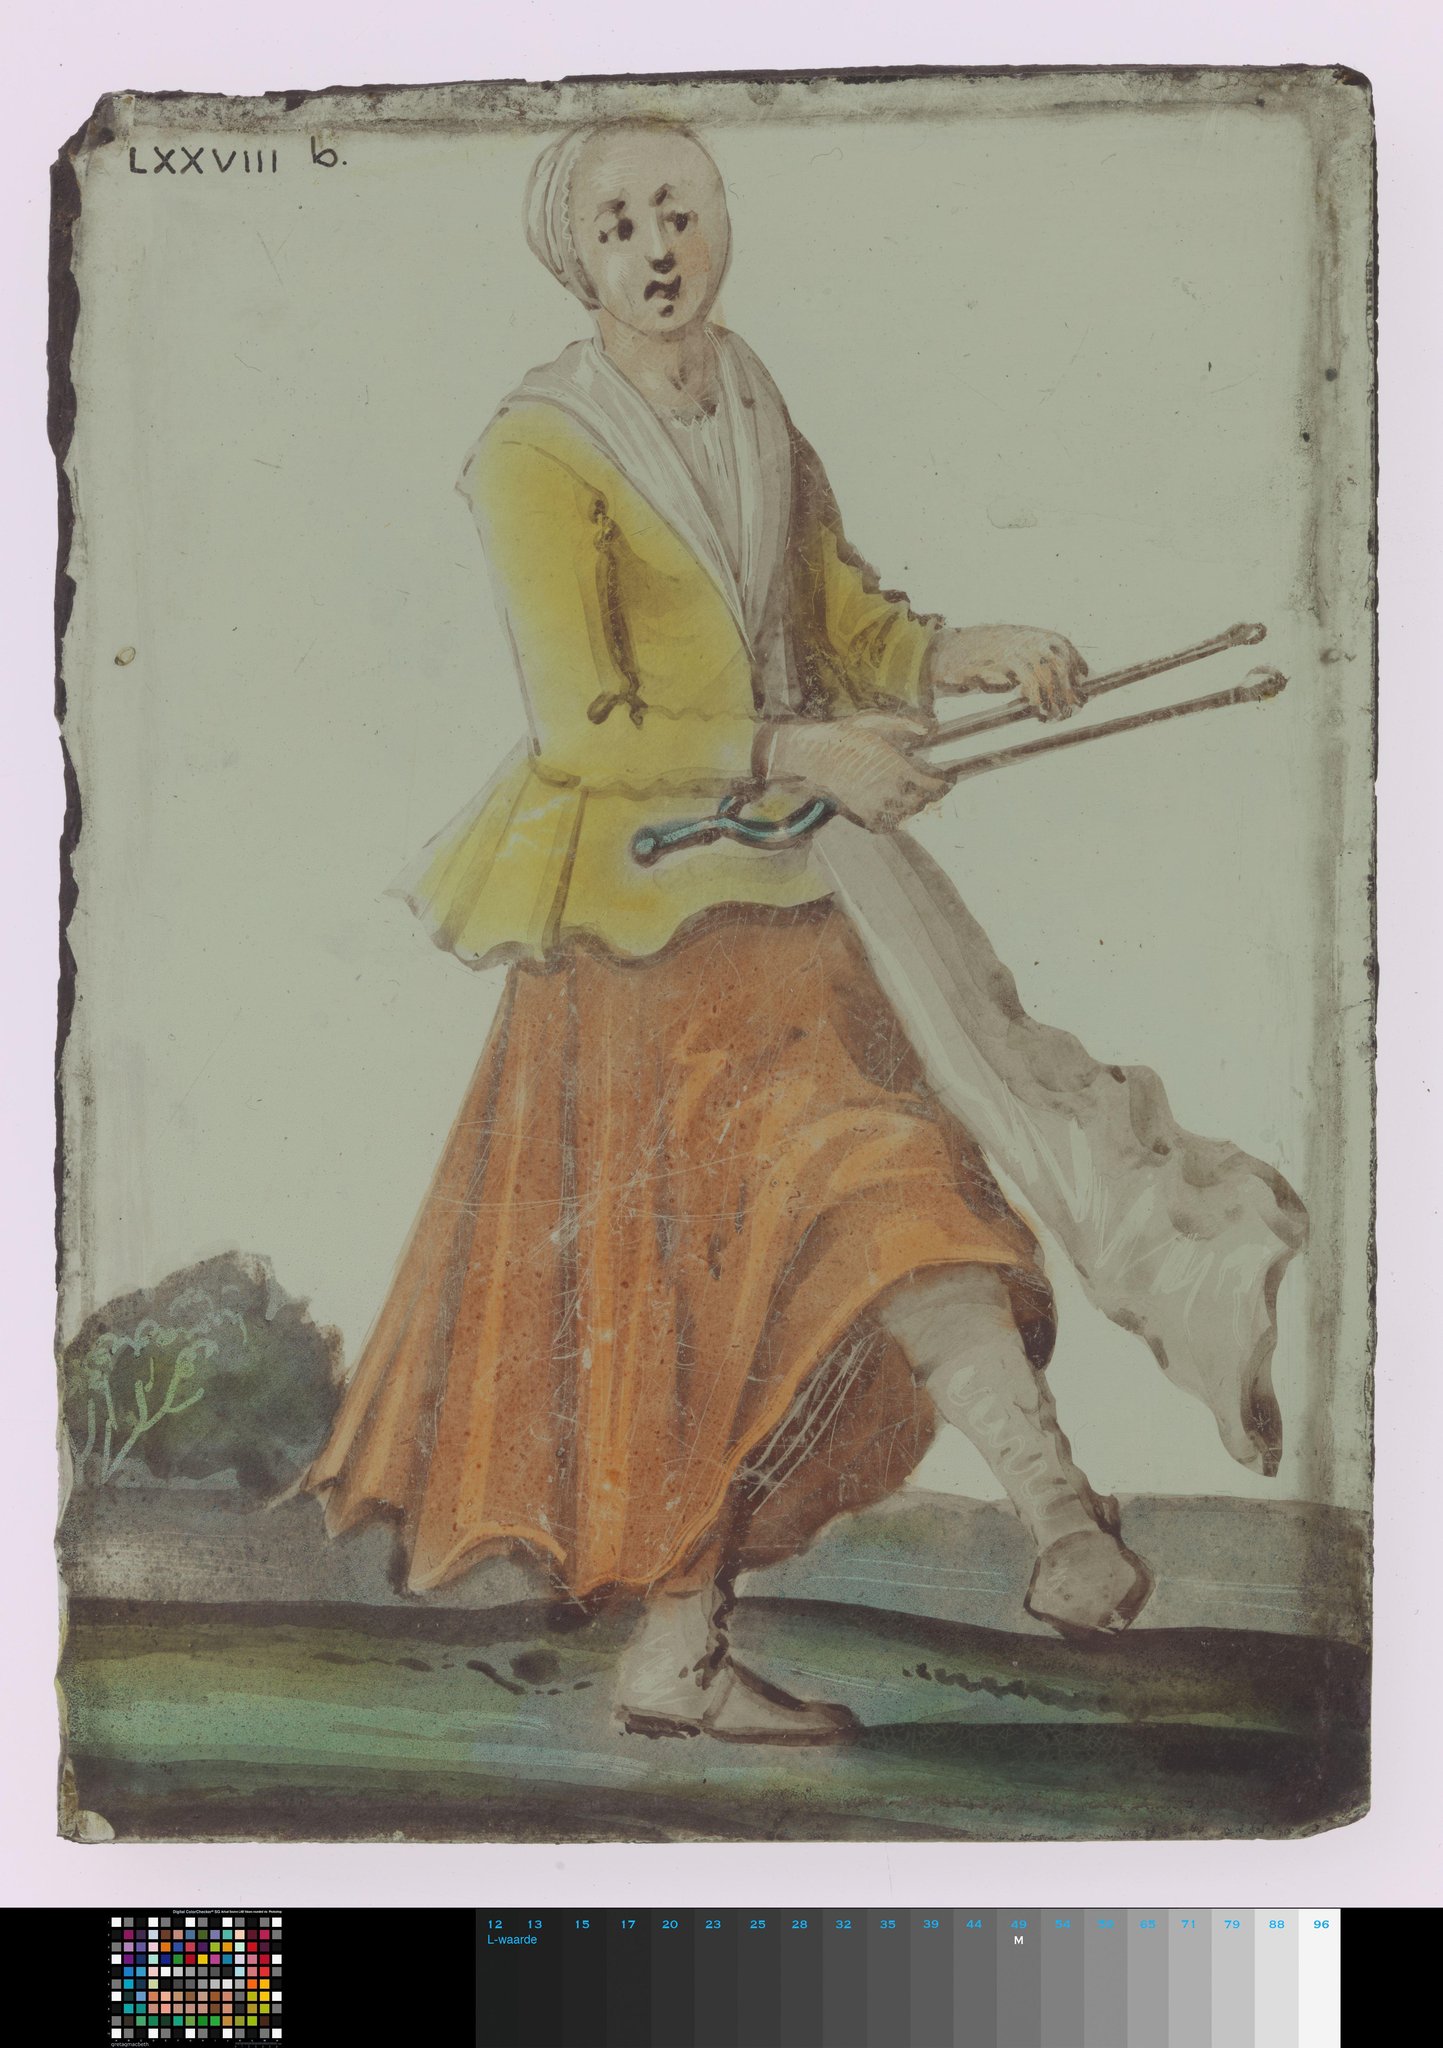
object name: light window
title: Ruit met een dansende vrouw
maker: Anonymous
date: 1650-1675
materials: glass, lead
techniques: enamel painting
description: Een ruit met emailschildering van een dansende vrouw met een tang in de hand, gekleurd.